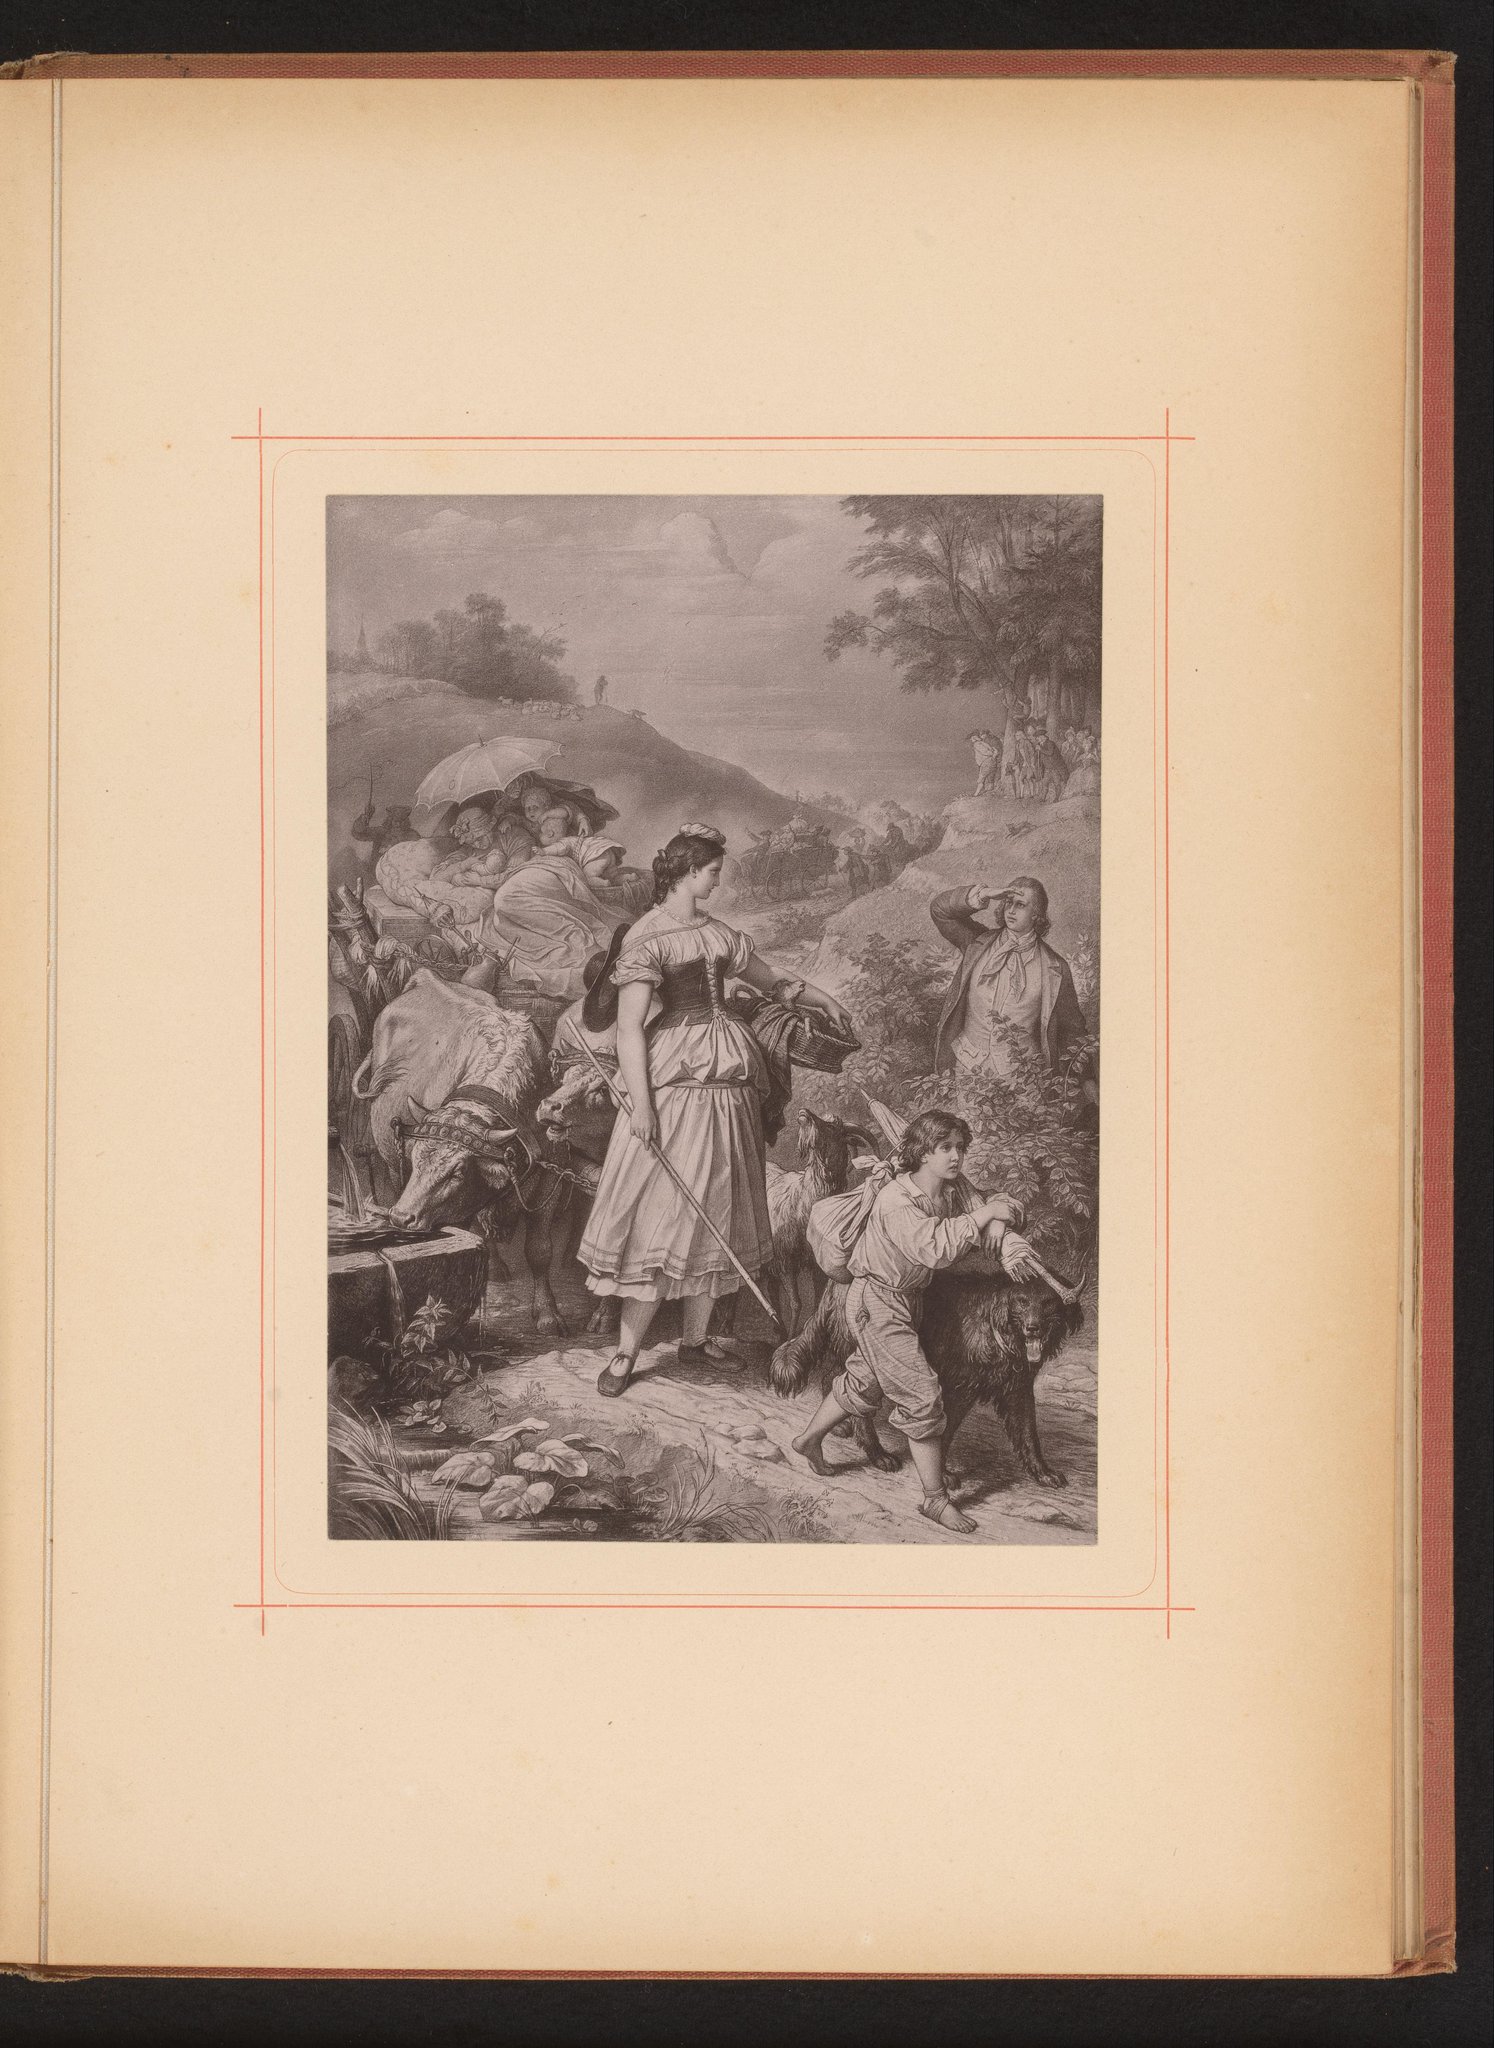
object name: reproduction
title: Reproductie van een tekening, voorstellende Hermann ziet Dorothea in de vluchtelingenstroom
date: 1880-1885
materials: paper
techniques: photograph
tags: adolescent, young woman, maiden, youth, adolescent, literary characters and objects, painting, drawing and the graphic arts